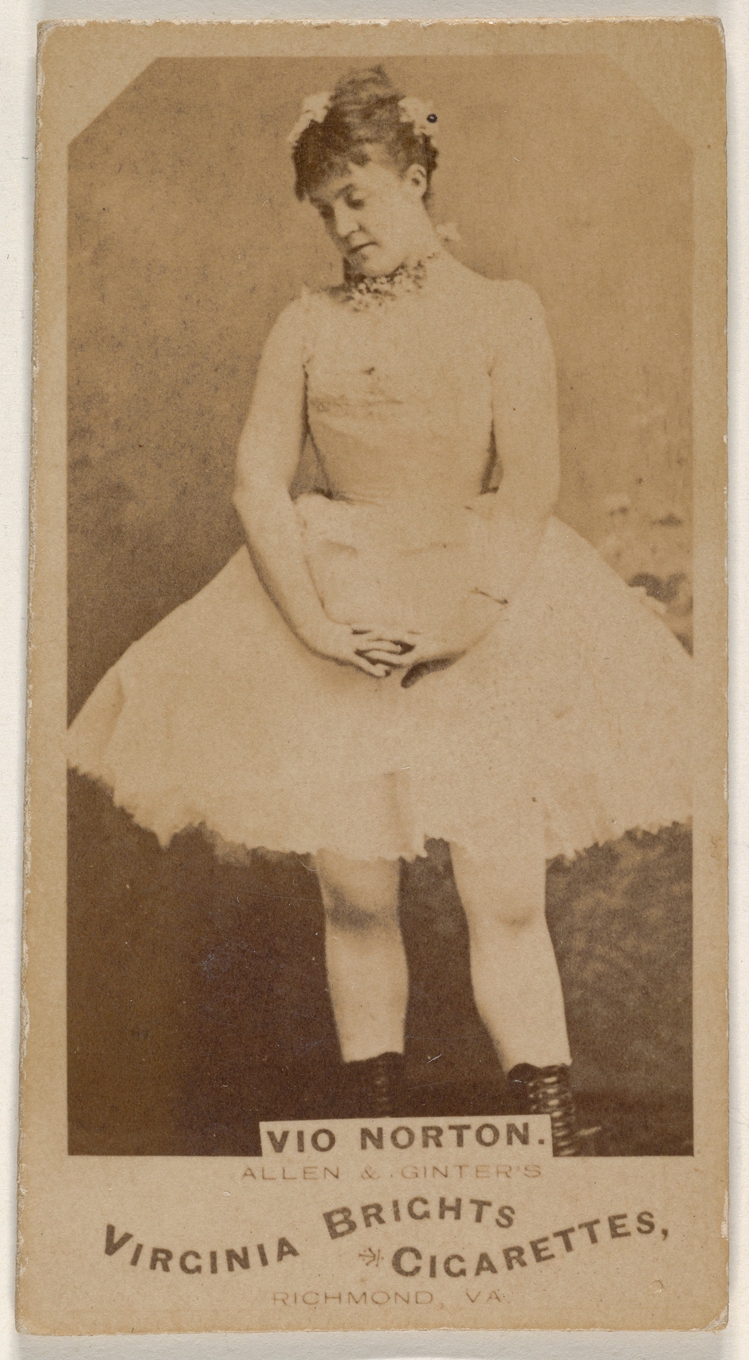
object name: photograph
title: Vio Norton, from the Actors and Actresses series (N45, Type 1) for Virginia Brights Cigarettes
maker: allen & ginter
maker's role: publisher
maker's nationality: american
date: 1888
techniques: albumen silver print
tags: portraits,women,actresses